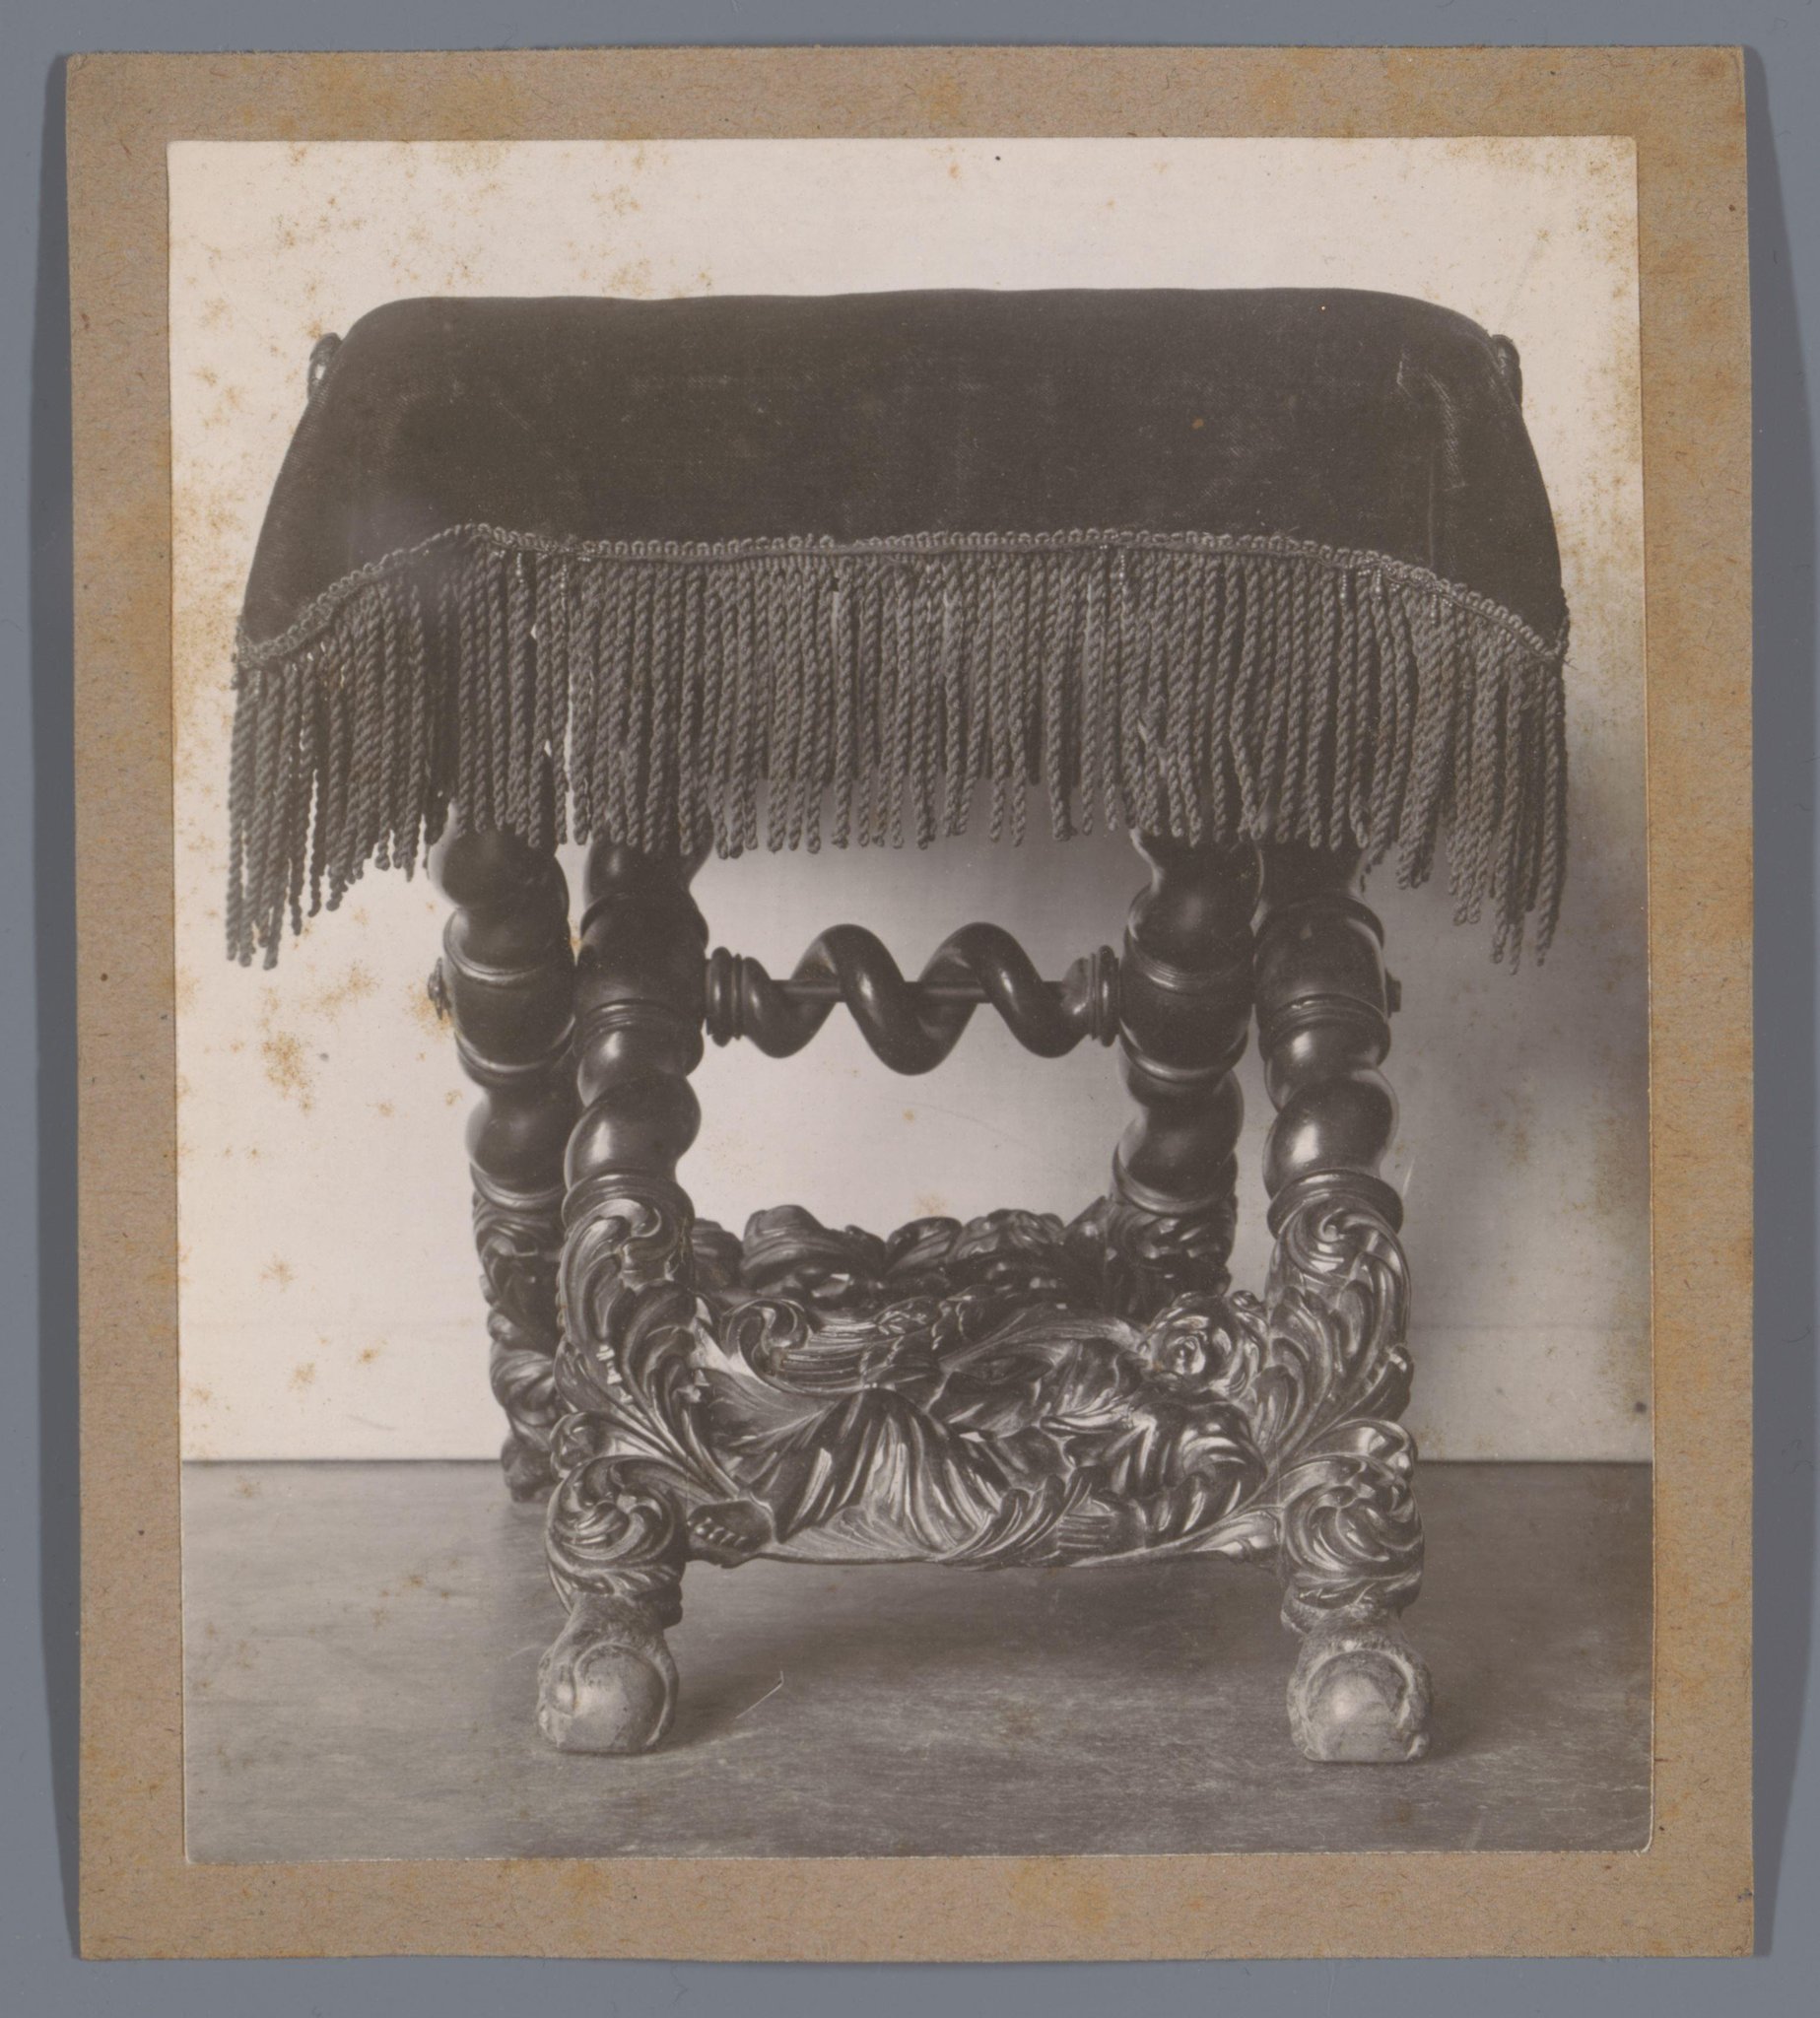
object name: photograph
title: Kruk met gedraaide poten gedecoreerd met bladmotieven en een liggende figuur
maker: Anonymous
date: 1875-1900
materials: photographic support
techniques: matte daylight collodion silver print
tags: stool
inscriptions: collector's mark: ‘Instituut voor kunst-nijverheidsonderwijs Gabriël Metsustraat No. 16, Amsterdam’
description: Zie voor een vergelijkbare foto RP-F-00-8492.